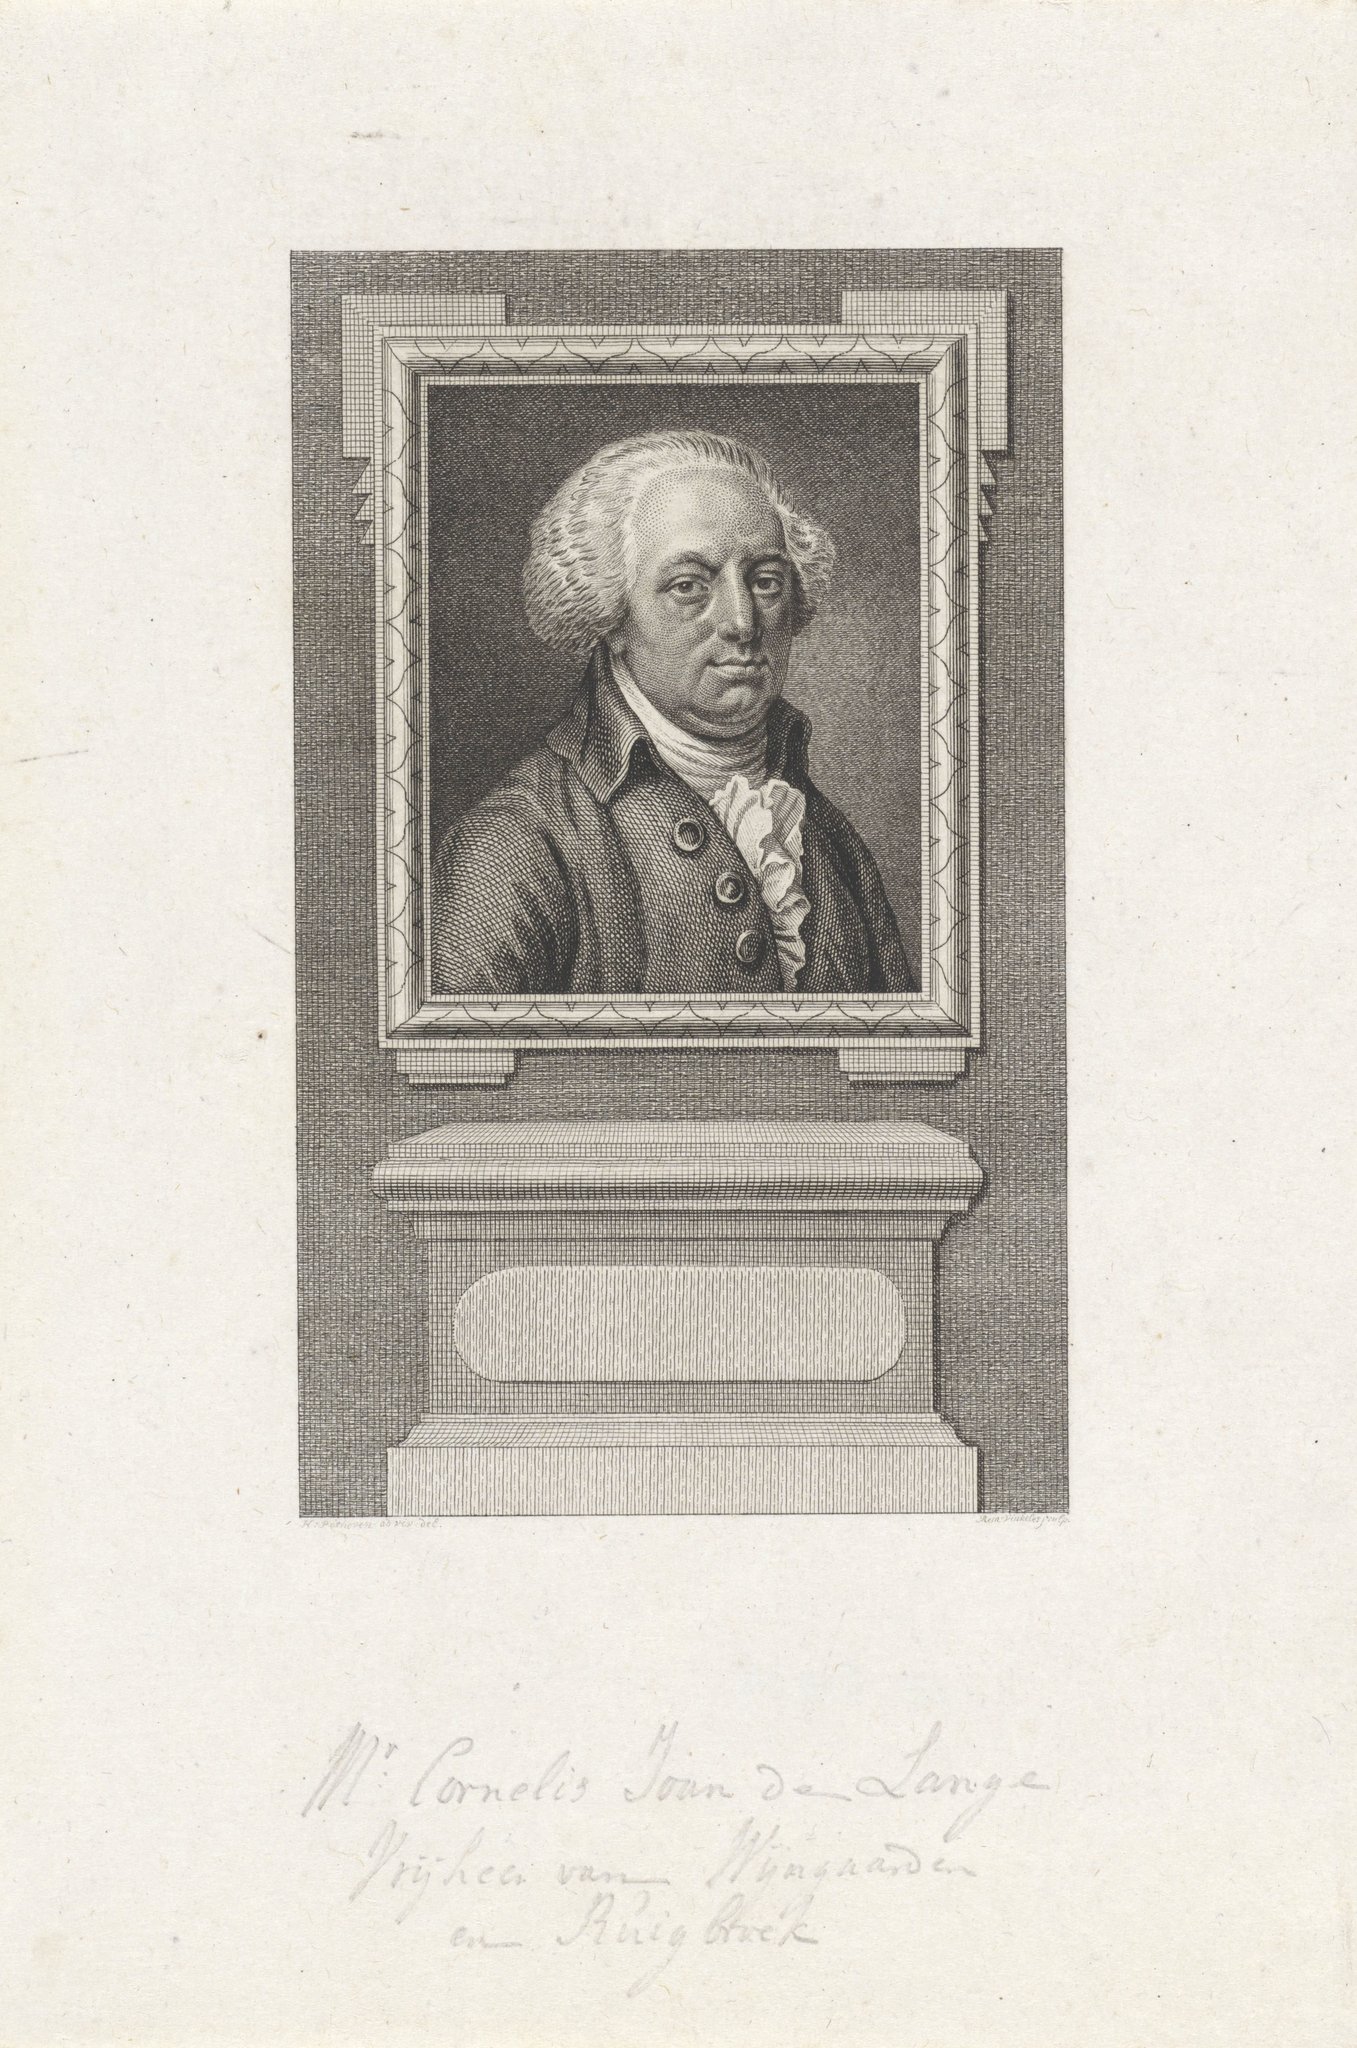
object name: print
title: Portret van Cornelis Johan de Lange van Wijngaarden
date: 1786-1809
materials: paper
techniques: engraving, etching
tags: gouda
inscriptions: collector's mark: Lugt 240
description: Latere staat prent ook gebruikt als boekillustratie in: Wagenaar, Jan. Vaderlandsche historie, (...) ten vervolge van Wagenaars Vaderlandsche historie. Dl. 1-43. Amsterdam: Johannes Allart, 1786-1809.